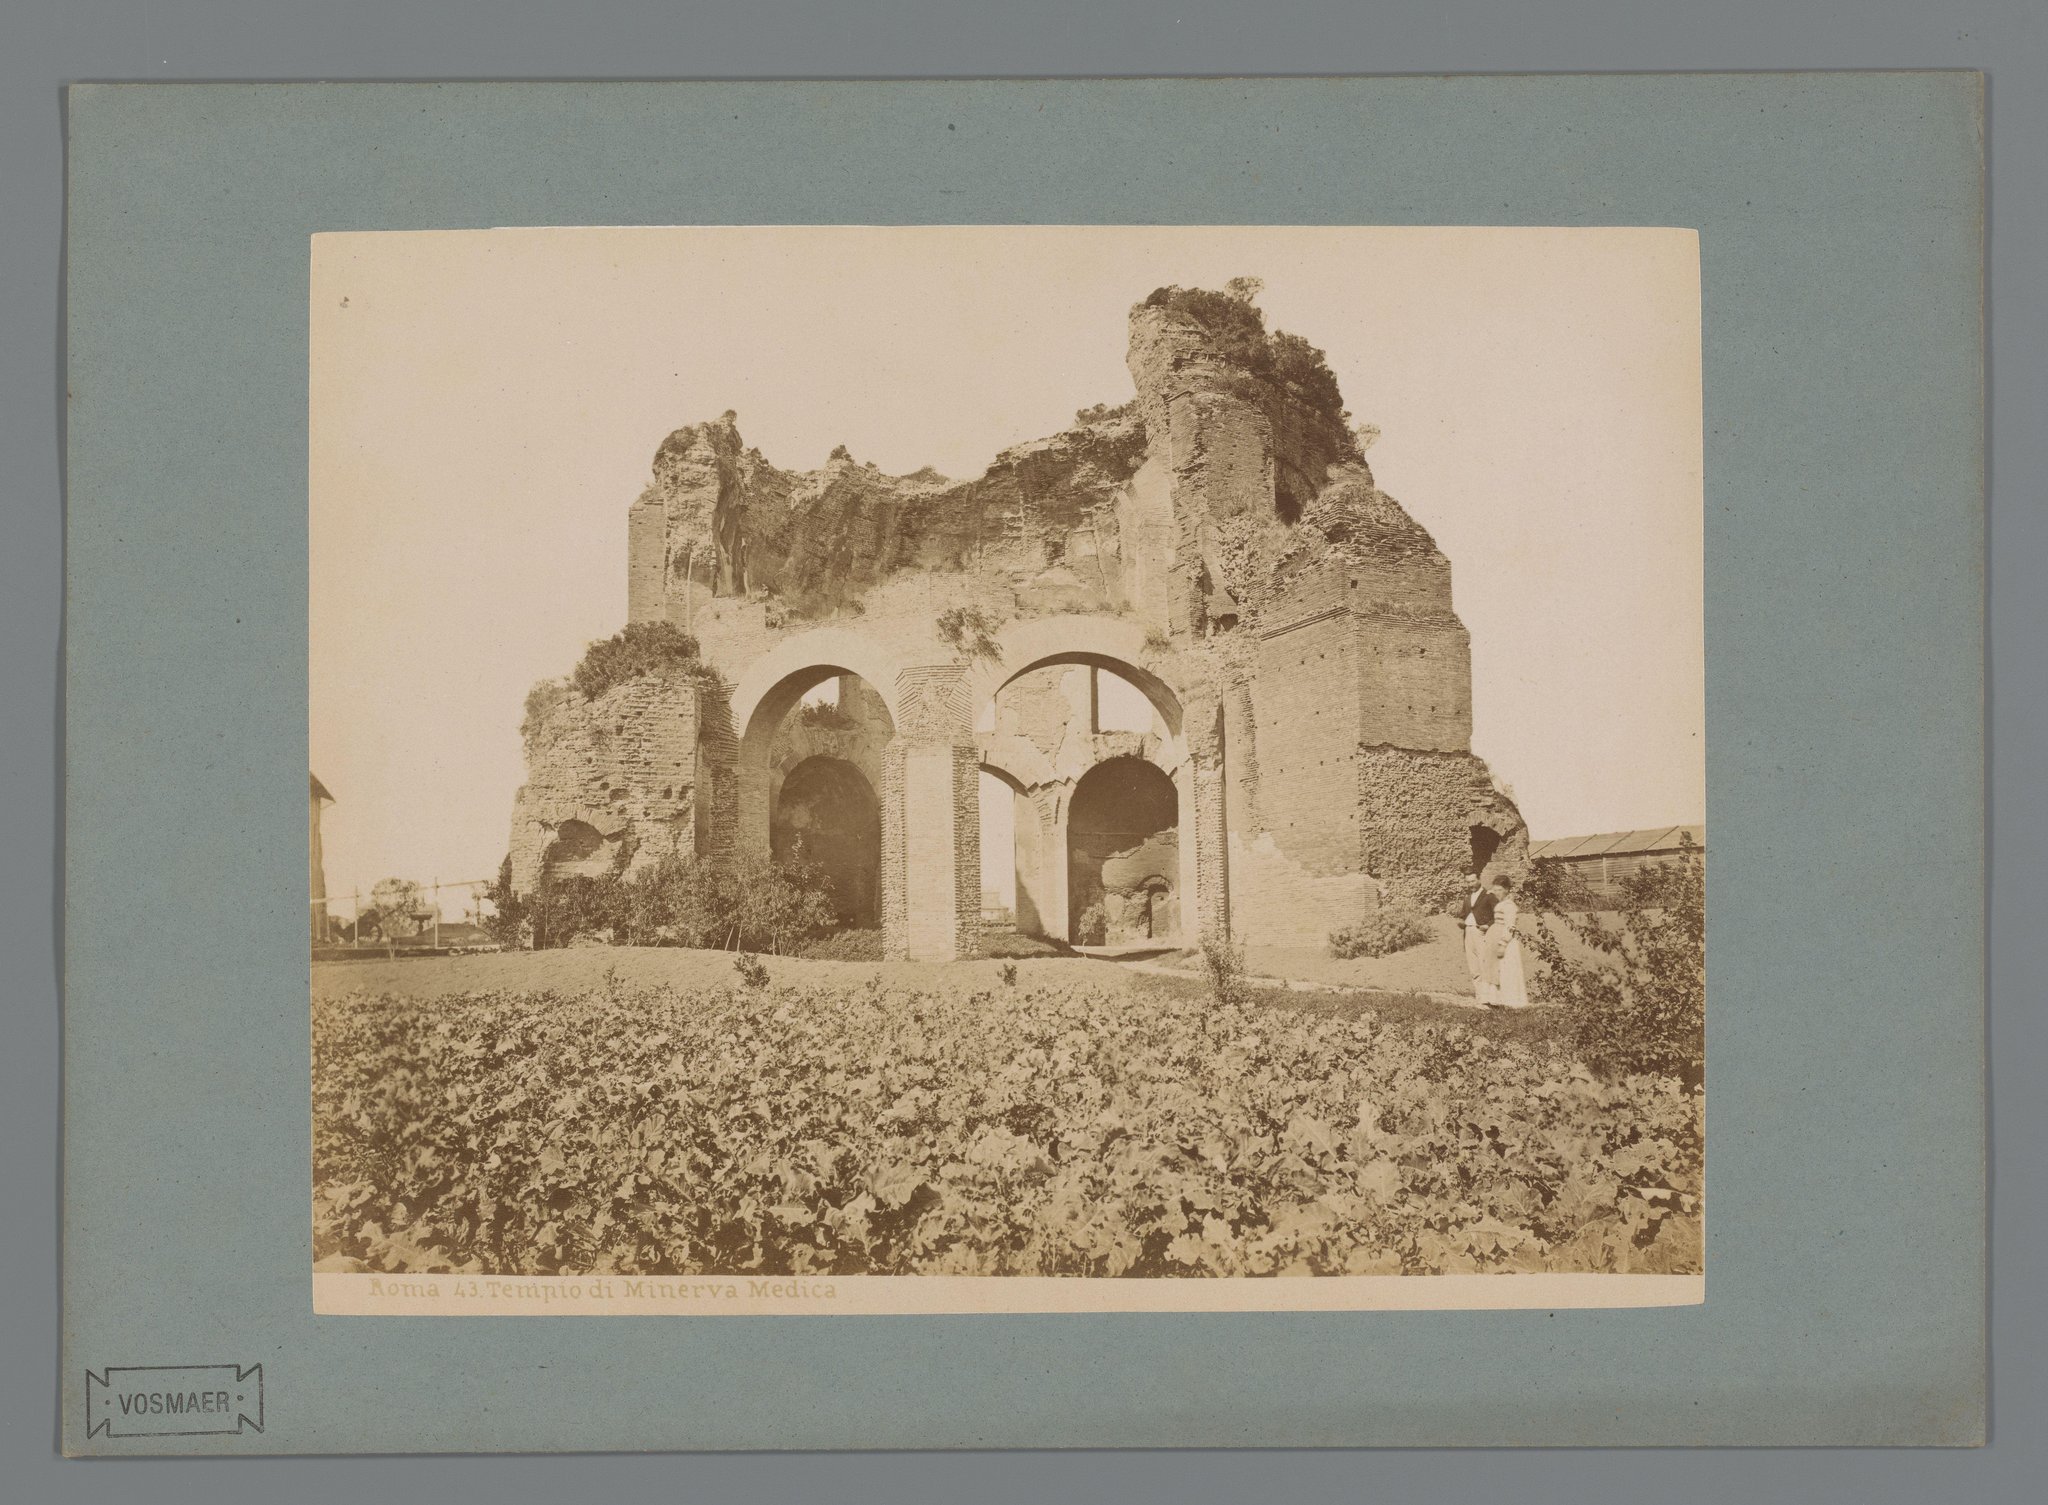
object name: photograph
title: Tempel van Minerva Medica te Rome, Italië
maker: Anonymous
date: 1851-1890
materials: cardboard, paper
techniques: albumen print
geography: rome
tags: ruin of church, monastery, etc.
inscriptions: number: ‘43.’, collector's mark: ‘VOSMAER’